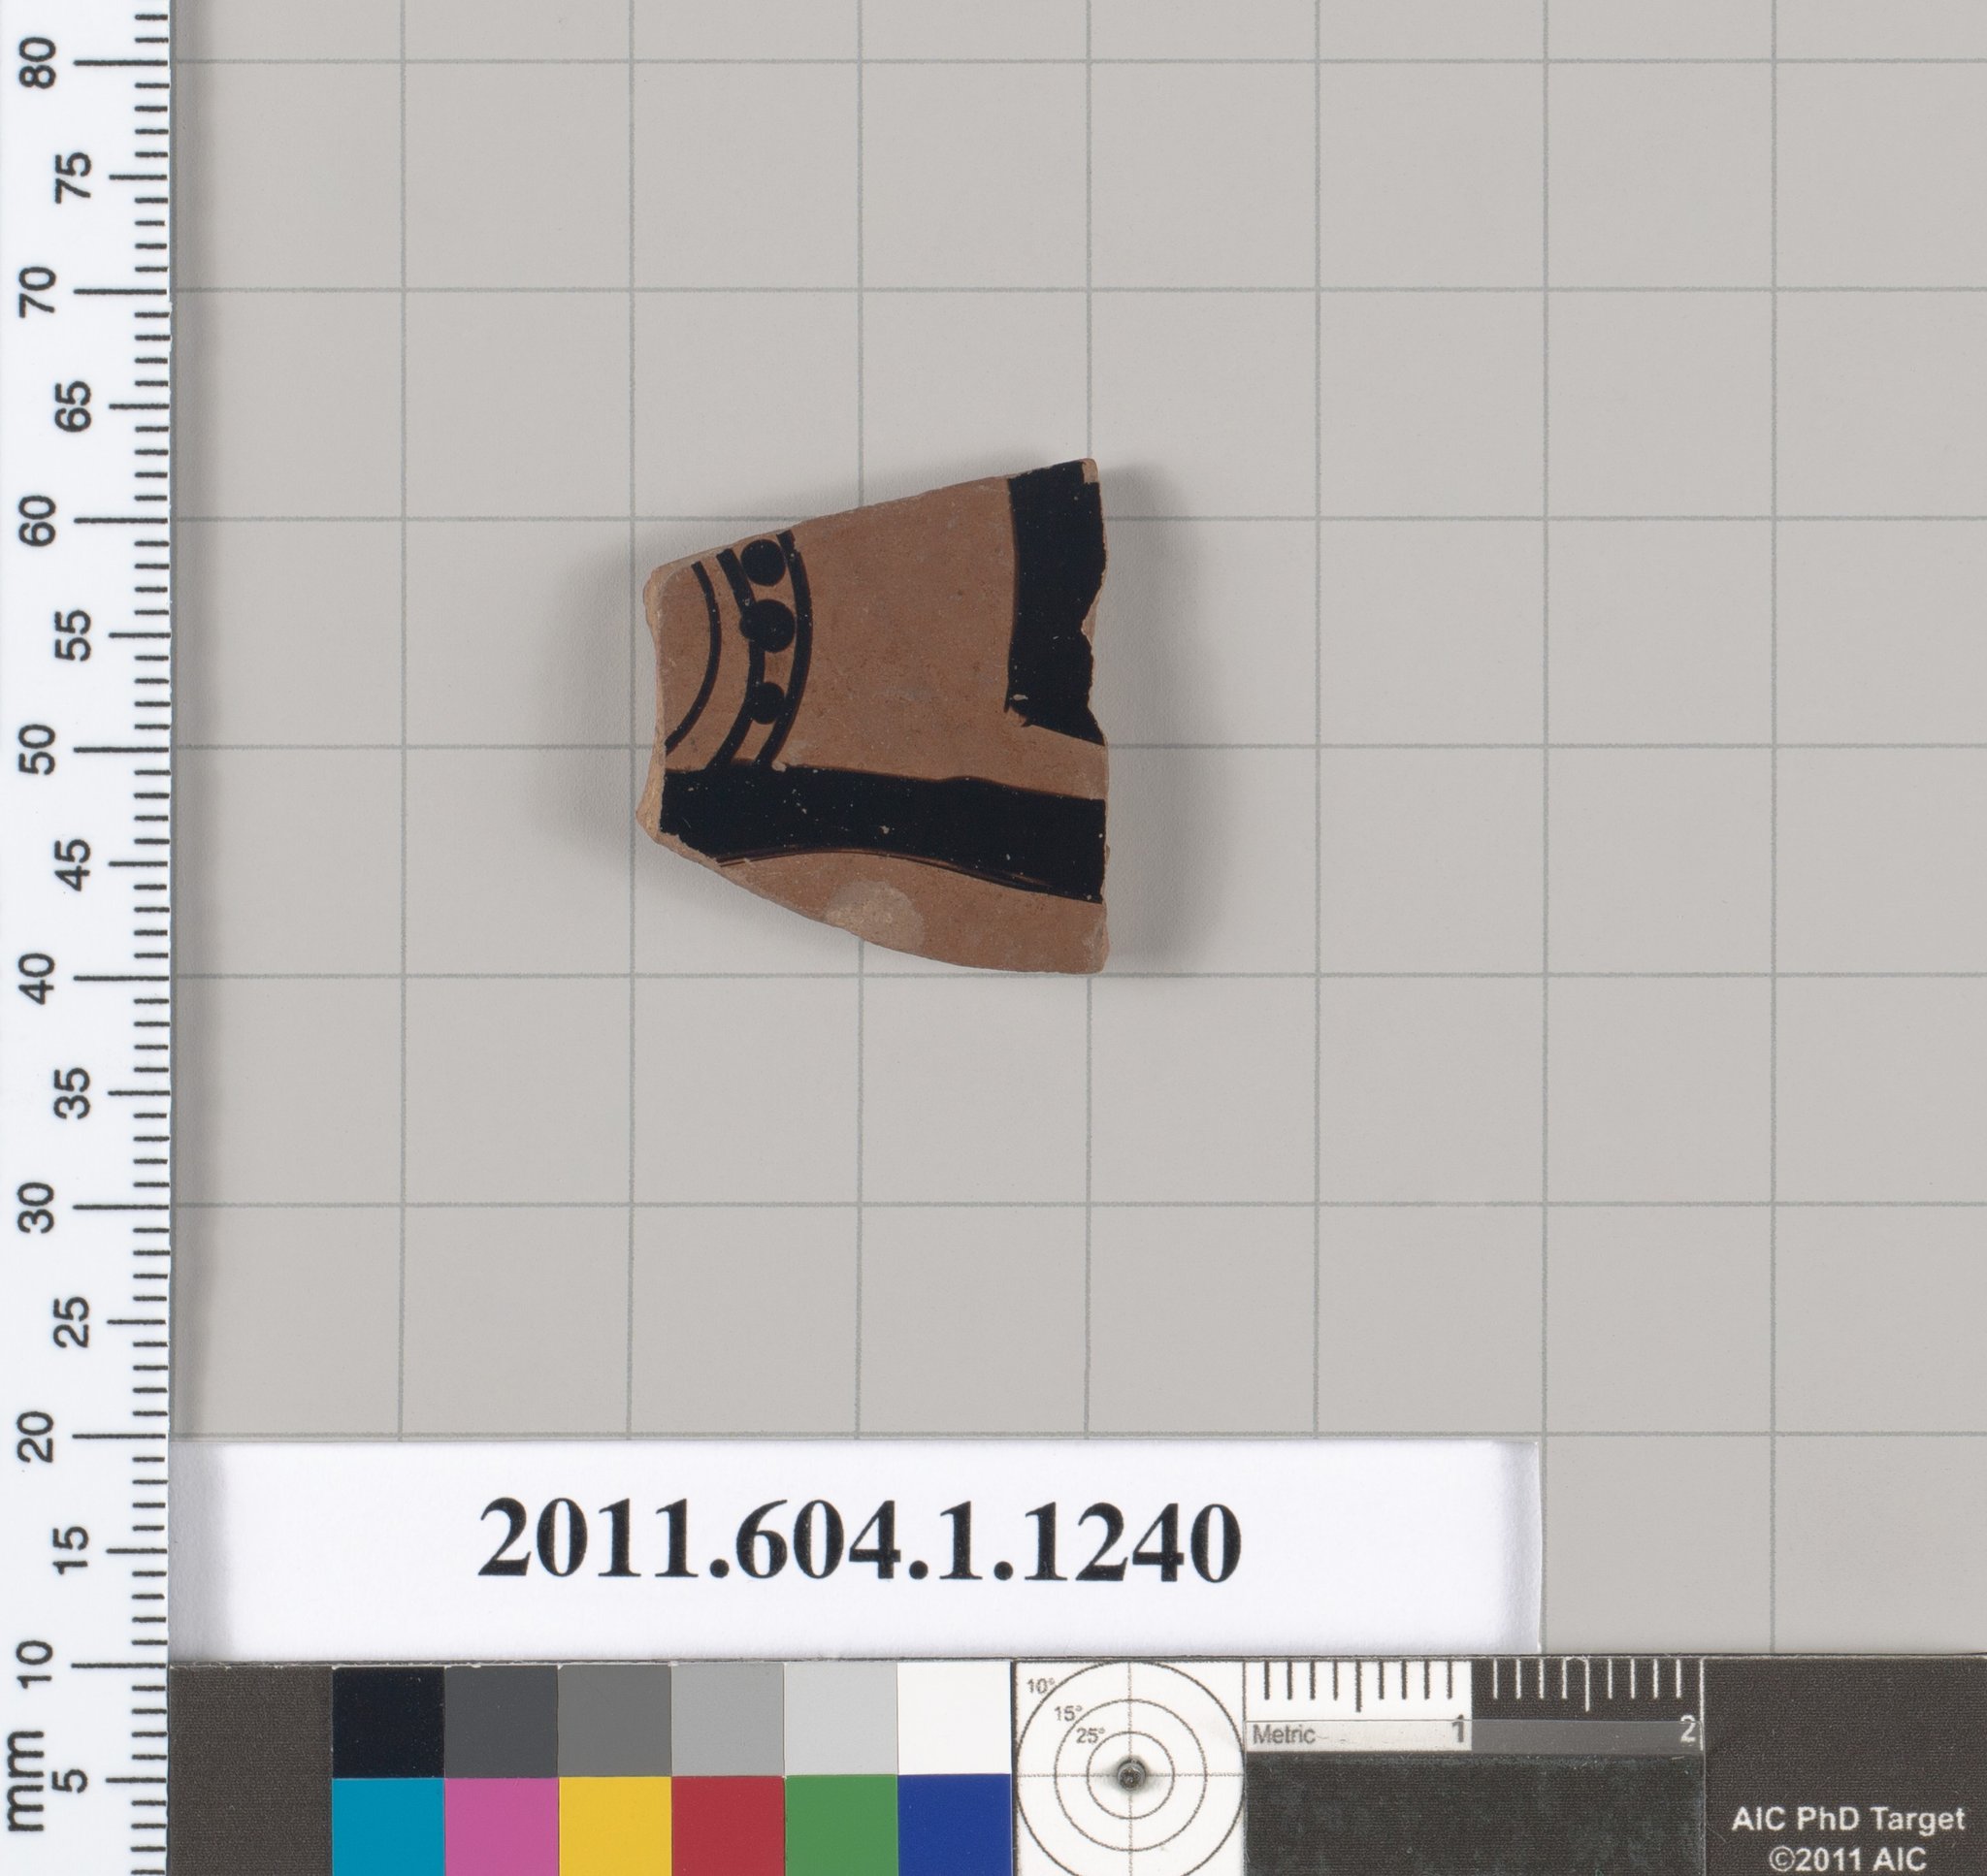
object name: kylix fragment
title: Terracotta fragment of a kylix (drinking cup)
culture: greek, attic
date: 500-480 BCE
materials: terracotta